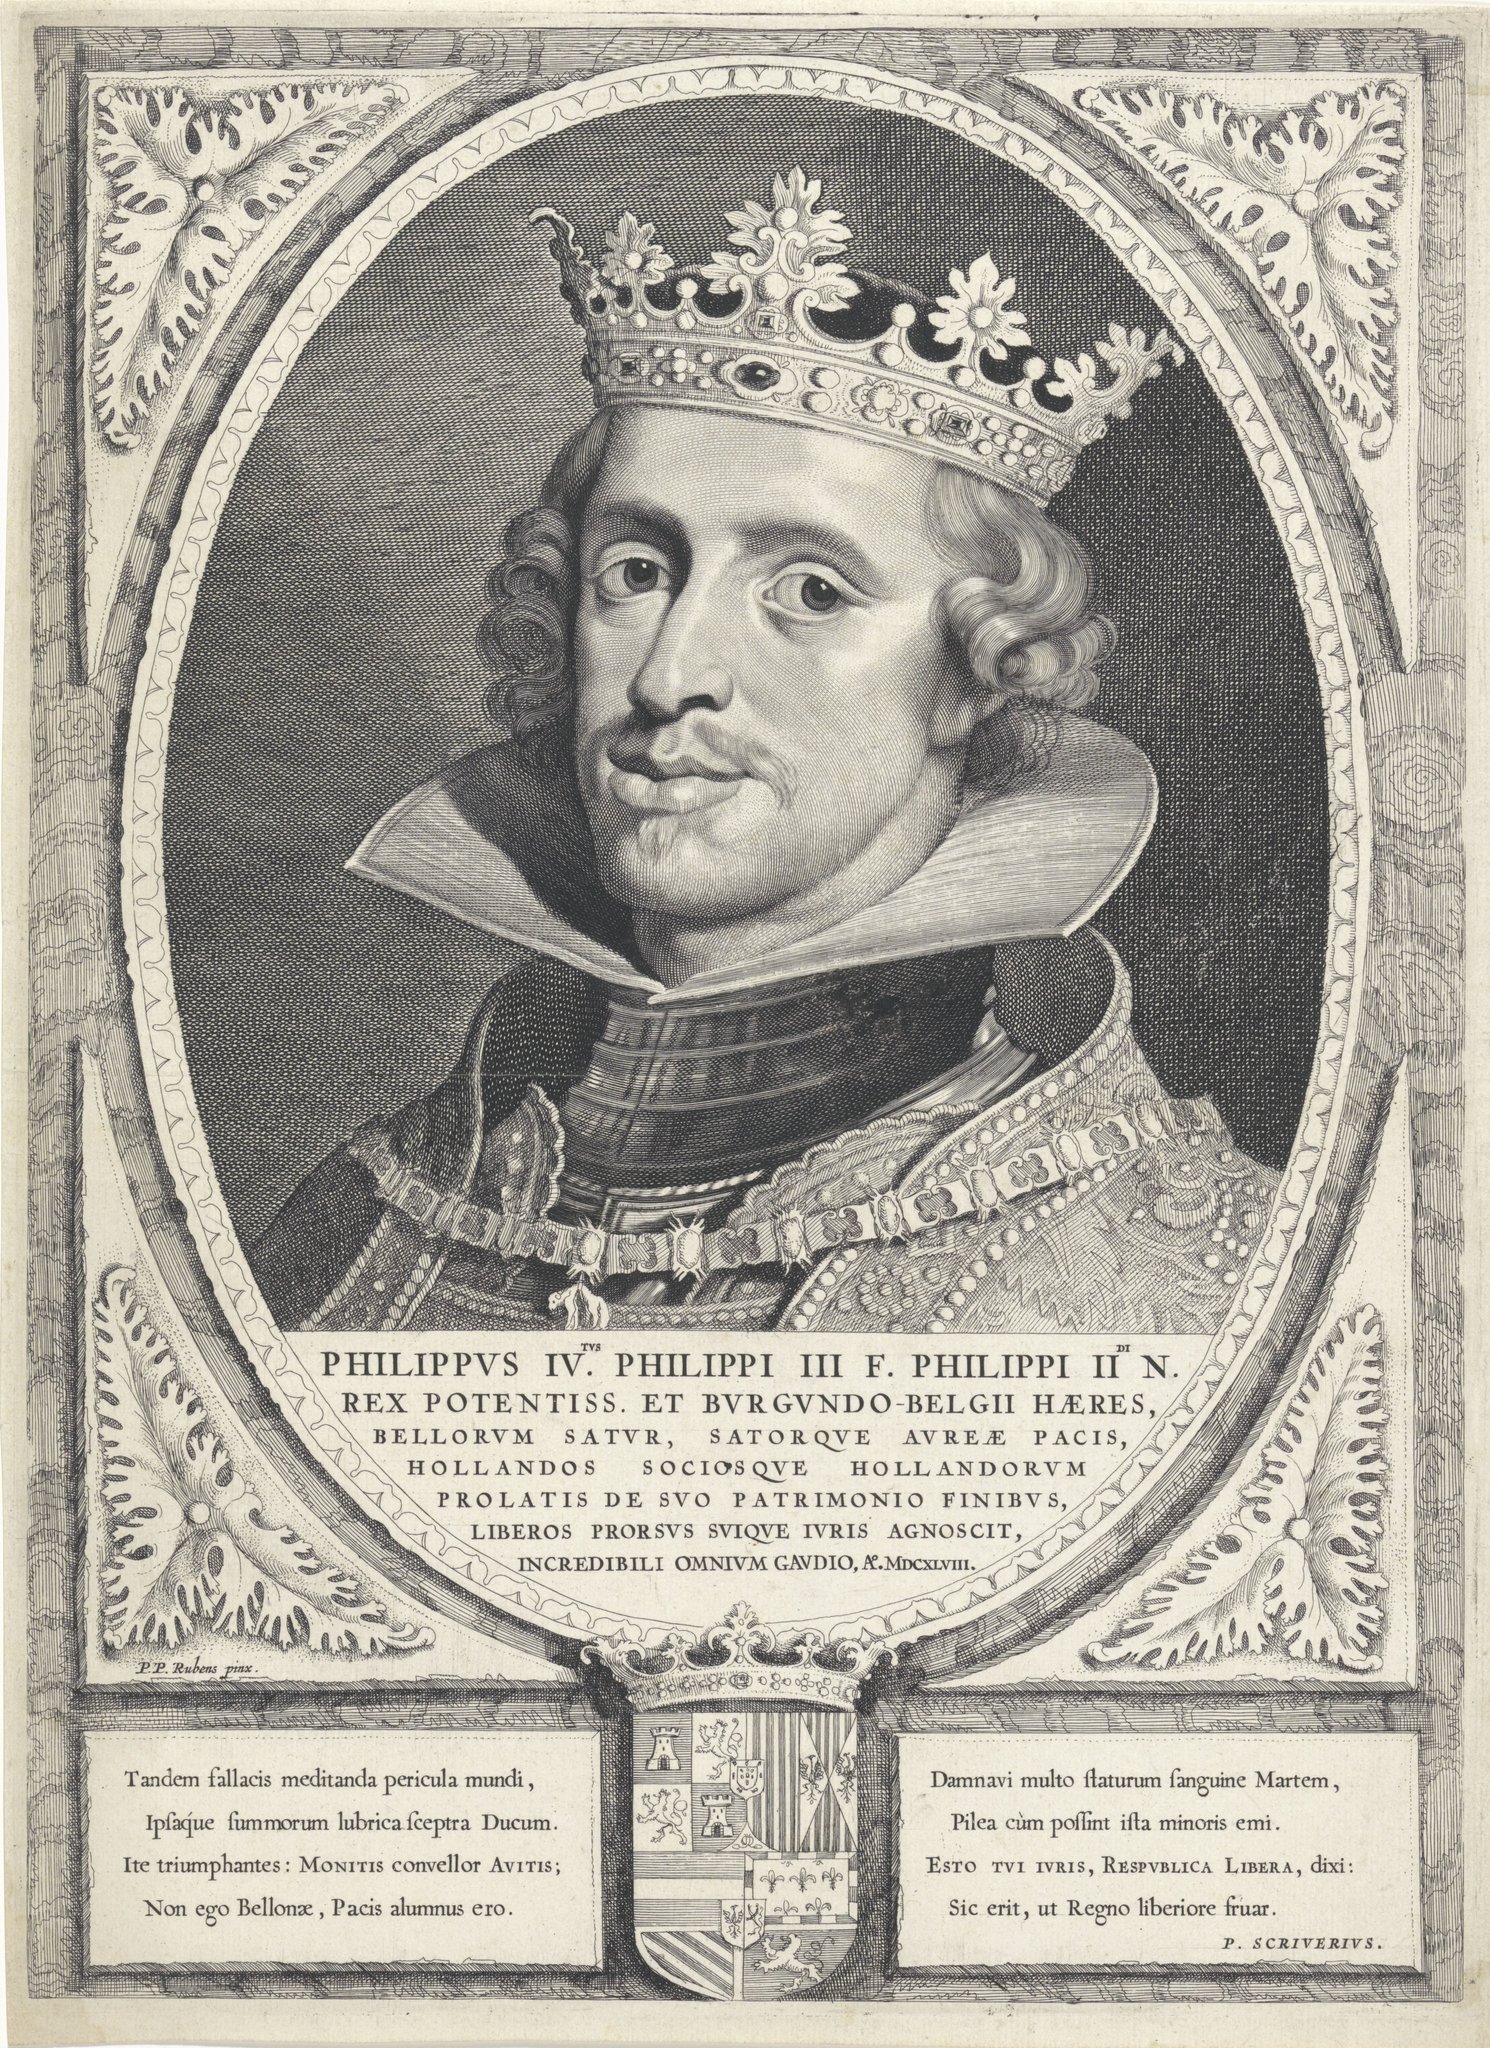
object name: print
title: Philippvs IV. Philippi III F. Philippi II N.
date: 1650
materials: paper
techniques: engraving, etching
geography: haarlem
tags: filips iv (koning van spanje), crown (symbol of sovereignty), armour, knighthood order of the golden fleece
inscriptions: collector's mark: Lugt 2228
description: Filips III, koning van Spanje met een brede kraag en een harnas. Op het hoofd een kroon en om zijn hals een keten met het ordeteken van de orde van het gulden vlies.